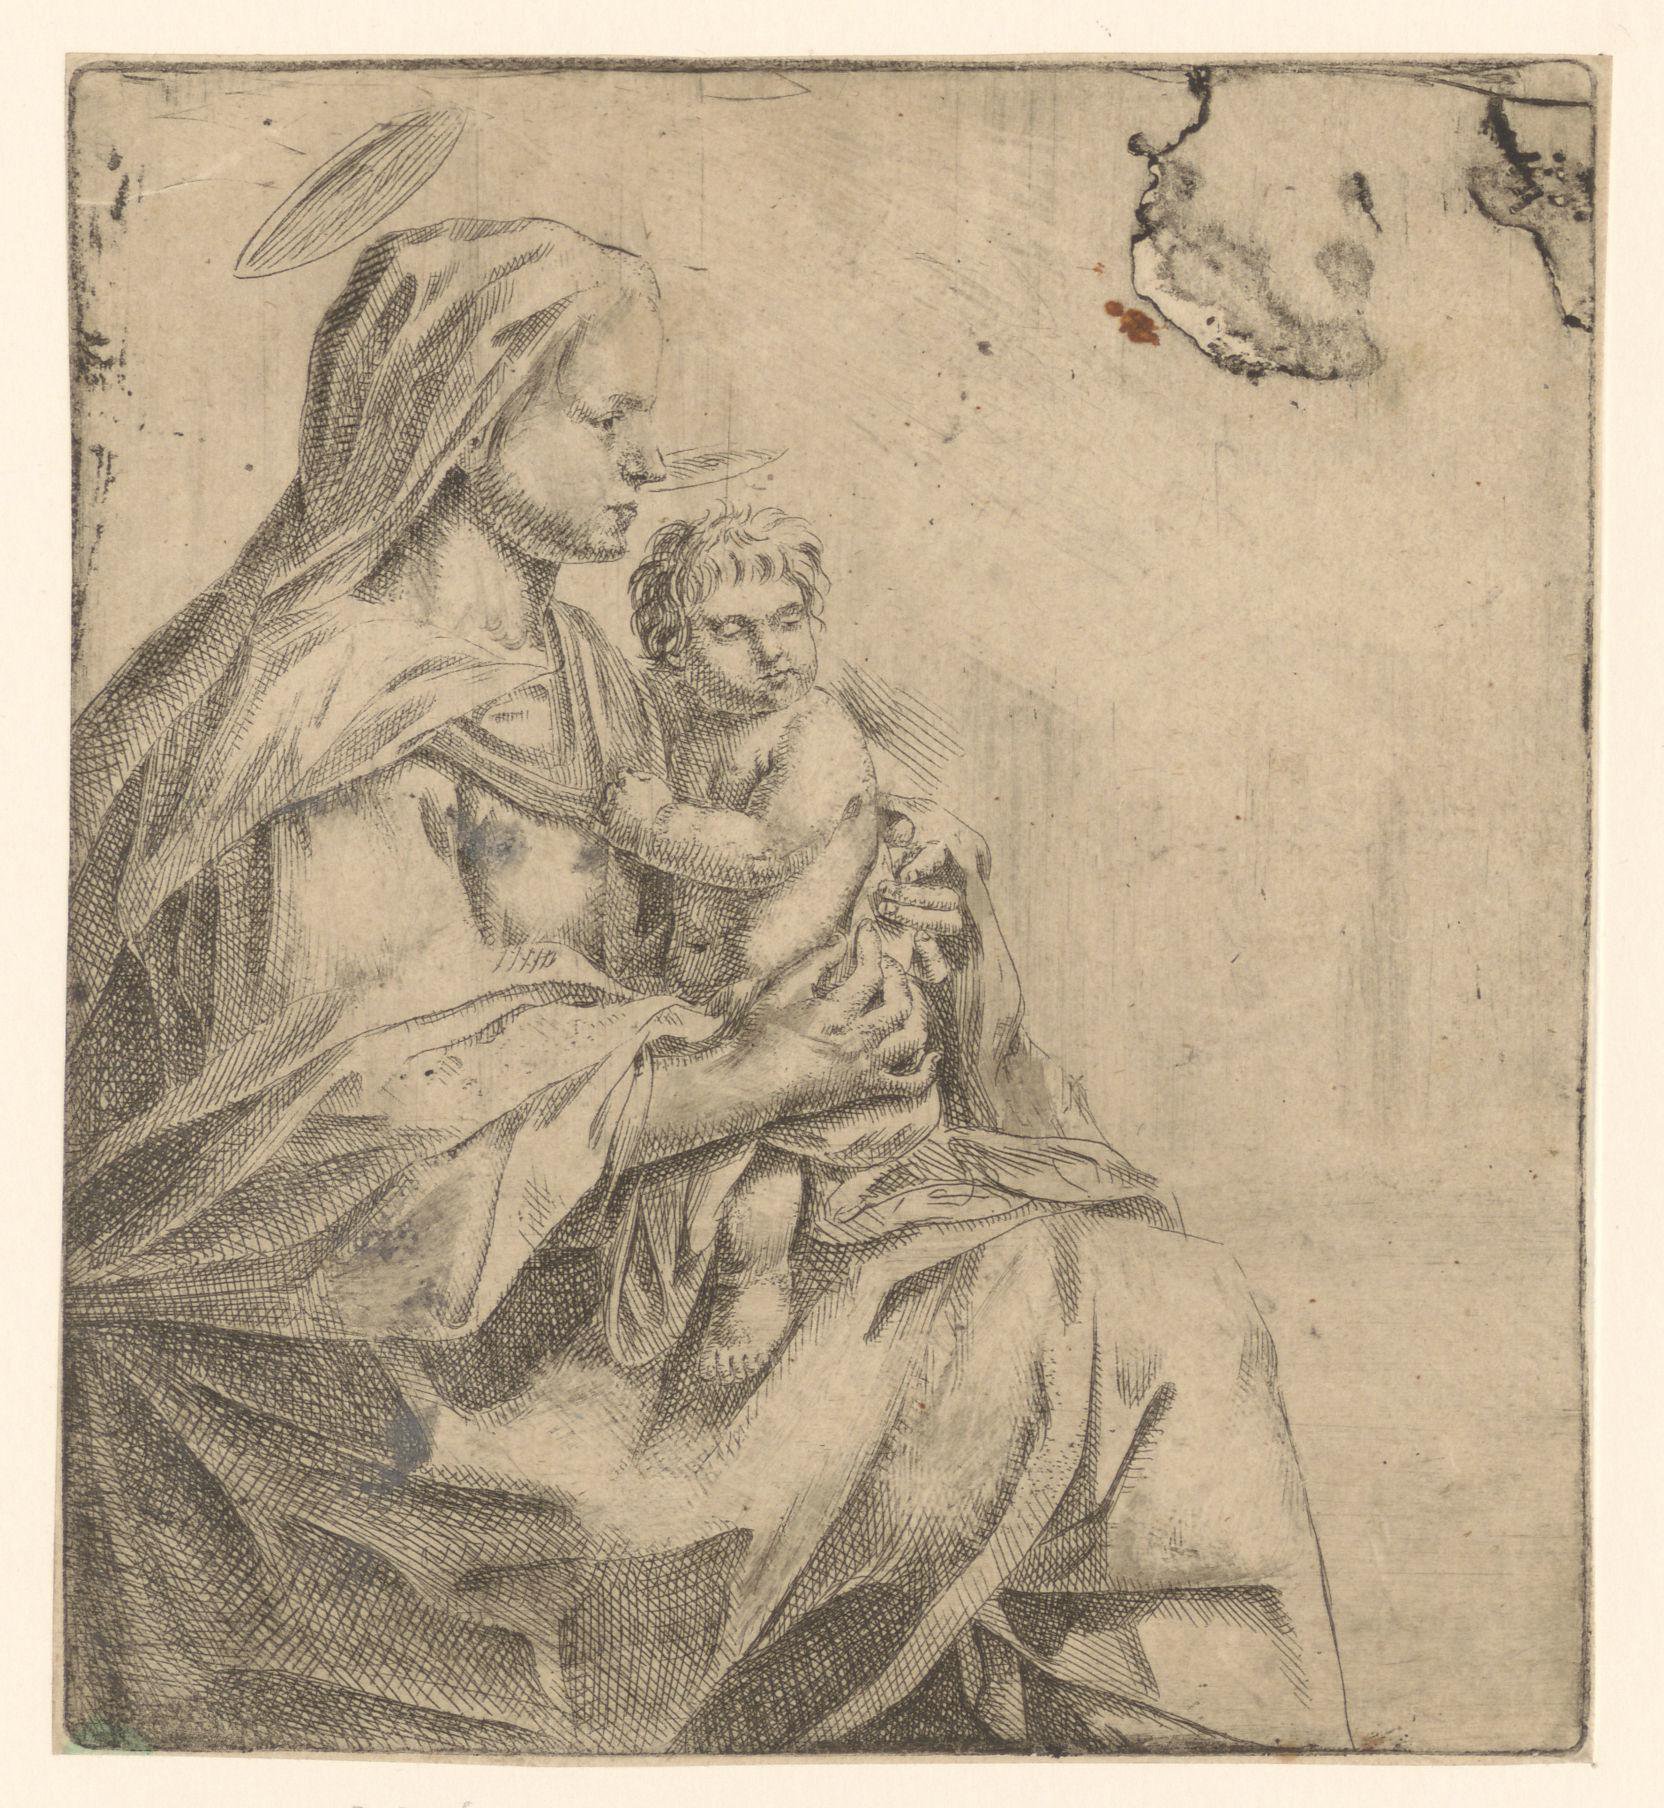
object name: print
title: Maria met Christuskind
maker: Anonymous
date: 1700-1800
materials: paper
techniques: etching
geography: england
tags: madonna: i.e. mary with the christ-child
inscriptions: collector's mark: Lugt 2228